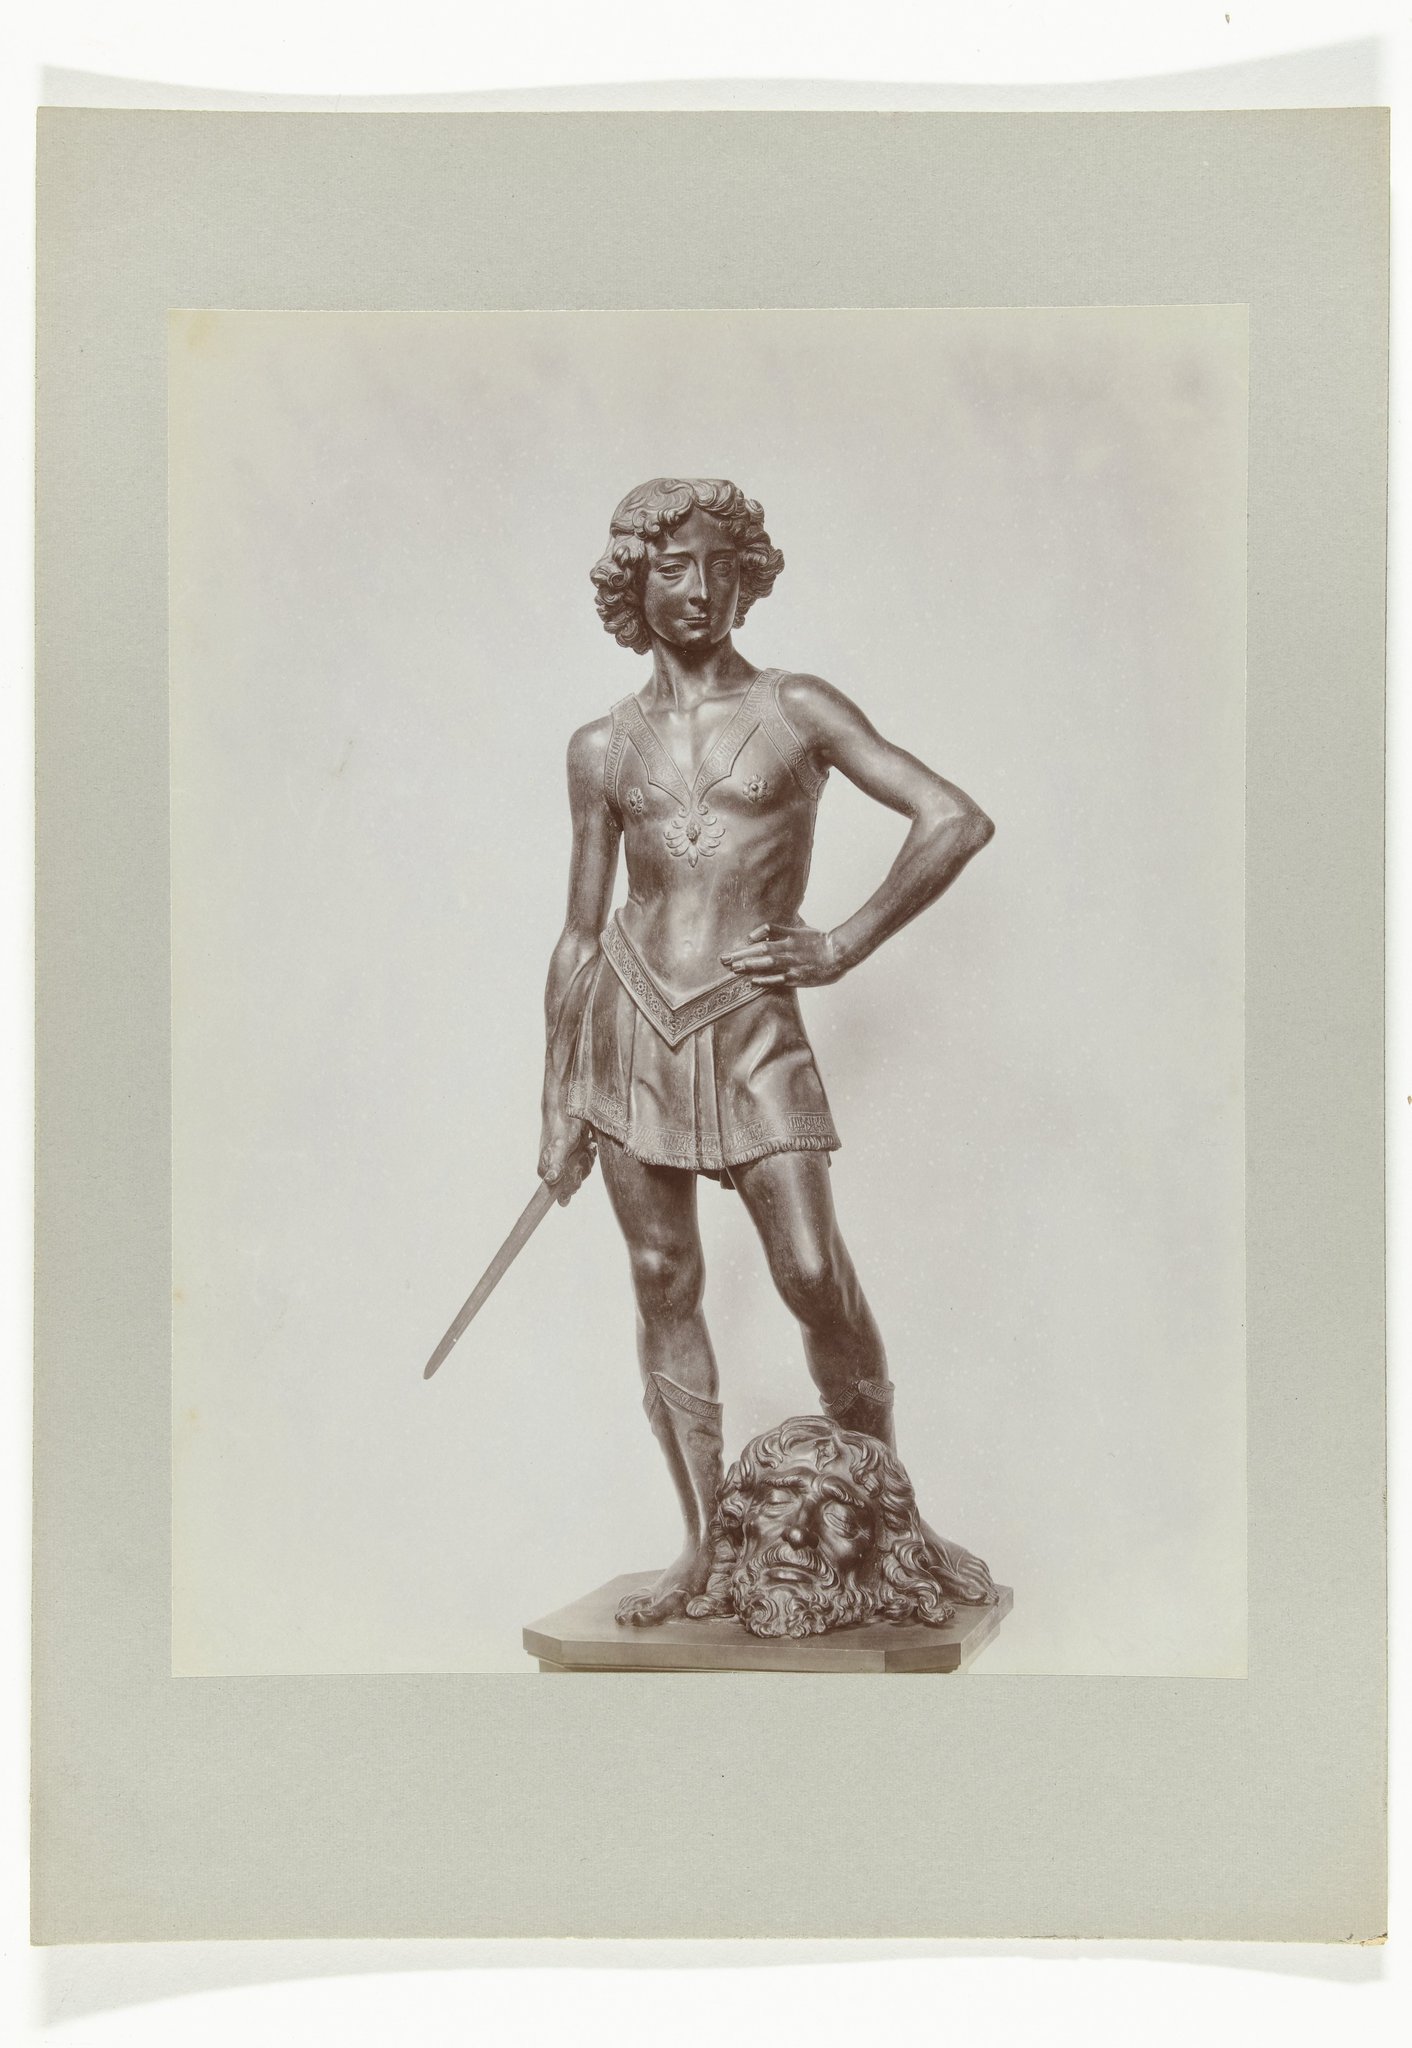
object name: photograph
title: Beeld van David met het hoofd van Goliath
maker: Anonymous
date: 1880-1904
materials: cardboard, paper, photographic support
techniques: albumen print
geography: italy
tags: italy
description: David heeft een zwaard in zijn hand, het hoofd van Goliath ligt aan zijn voeten.